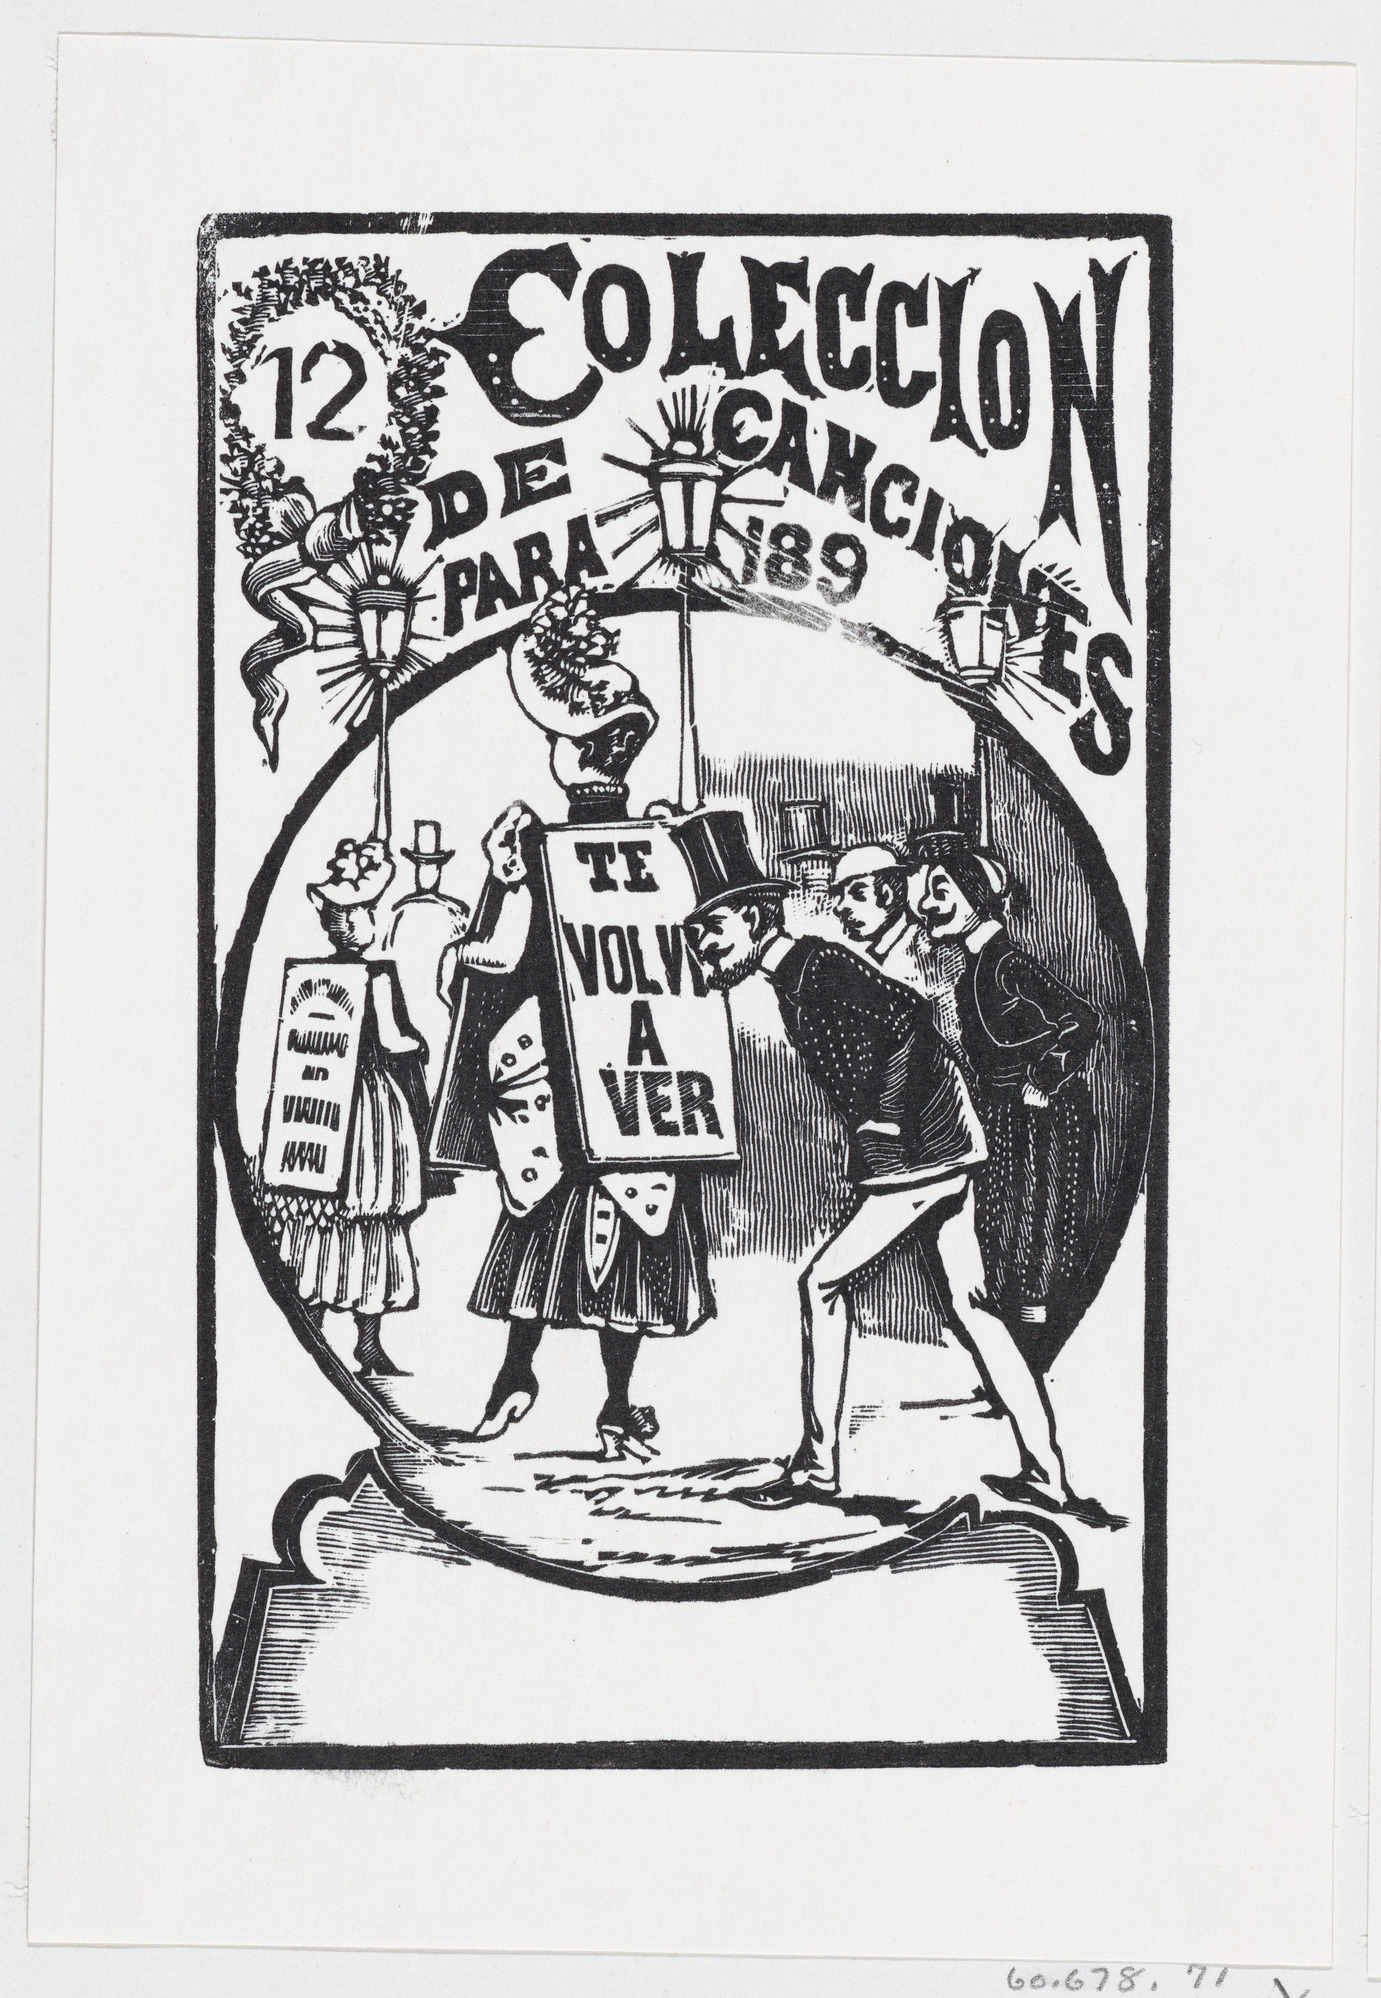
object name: print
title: A man bending down to look at a woman with a sign on her back, illustration for 'El Abanico (The Admirer)'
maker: josé guadalupe posada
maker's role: artist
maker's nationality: mexican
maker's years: 1852-1913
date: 1880-1910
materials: metal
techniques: engraving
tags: men,women